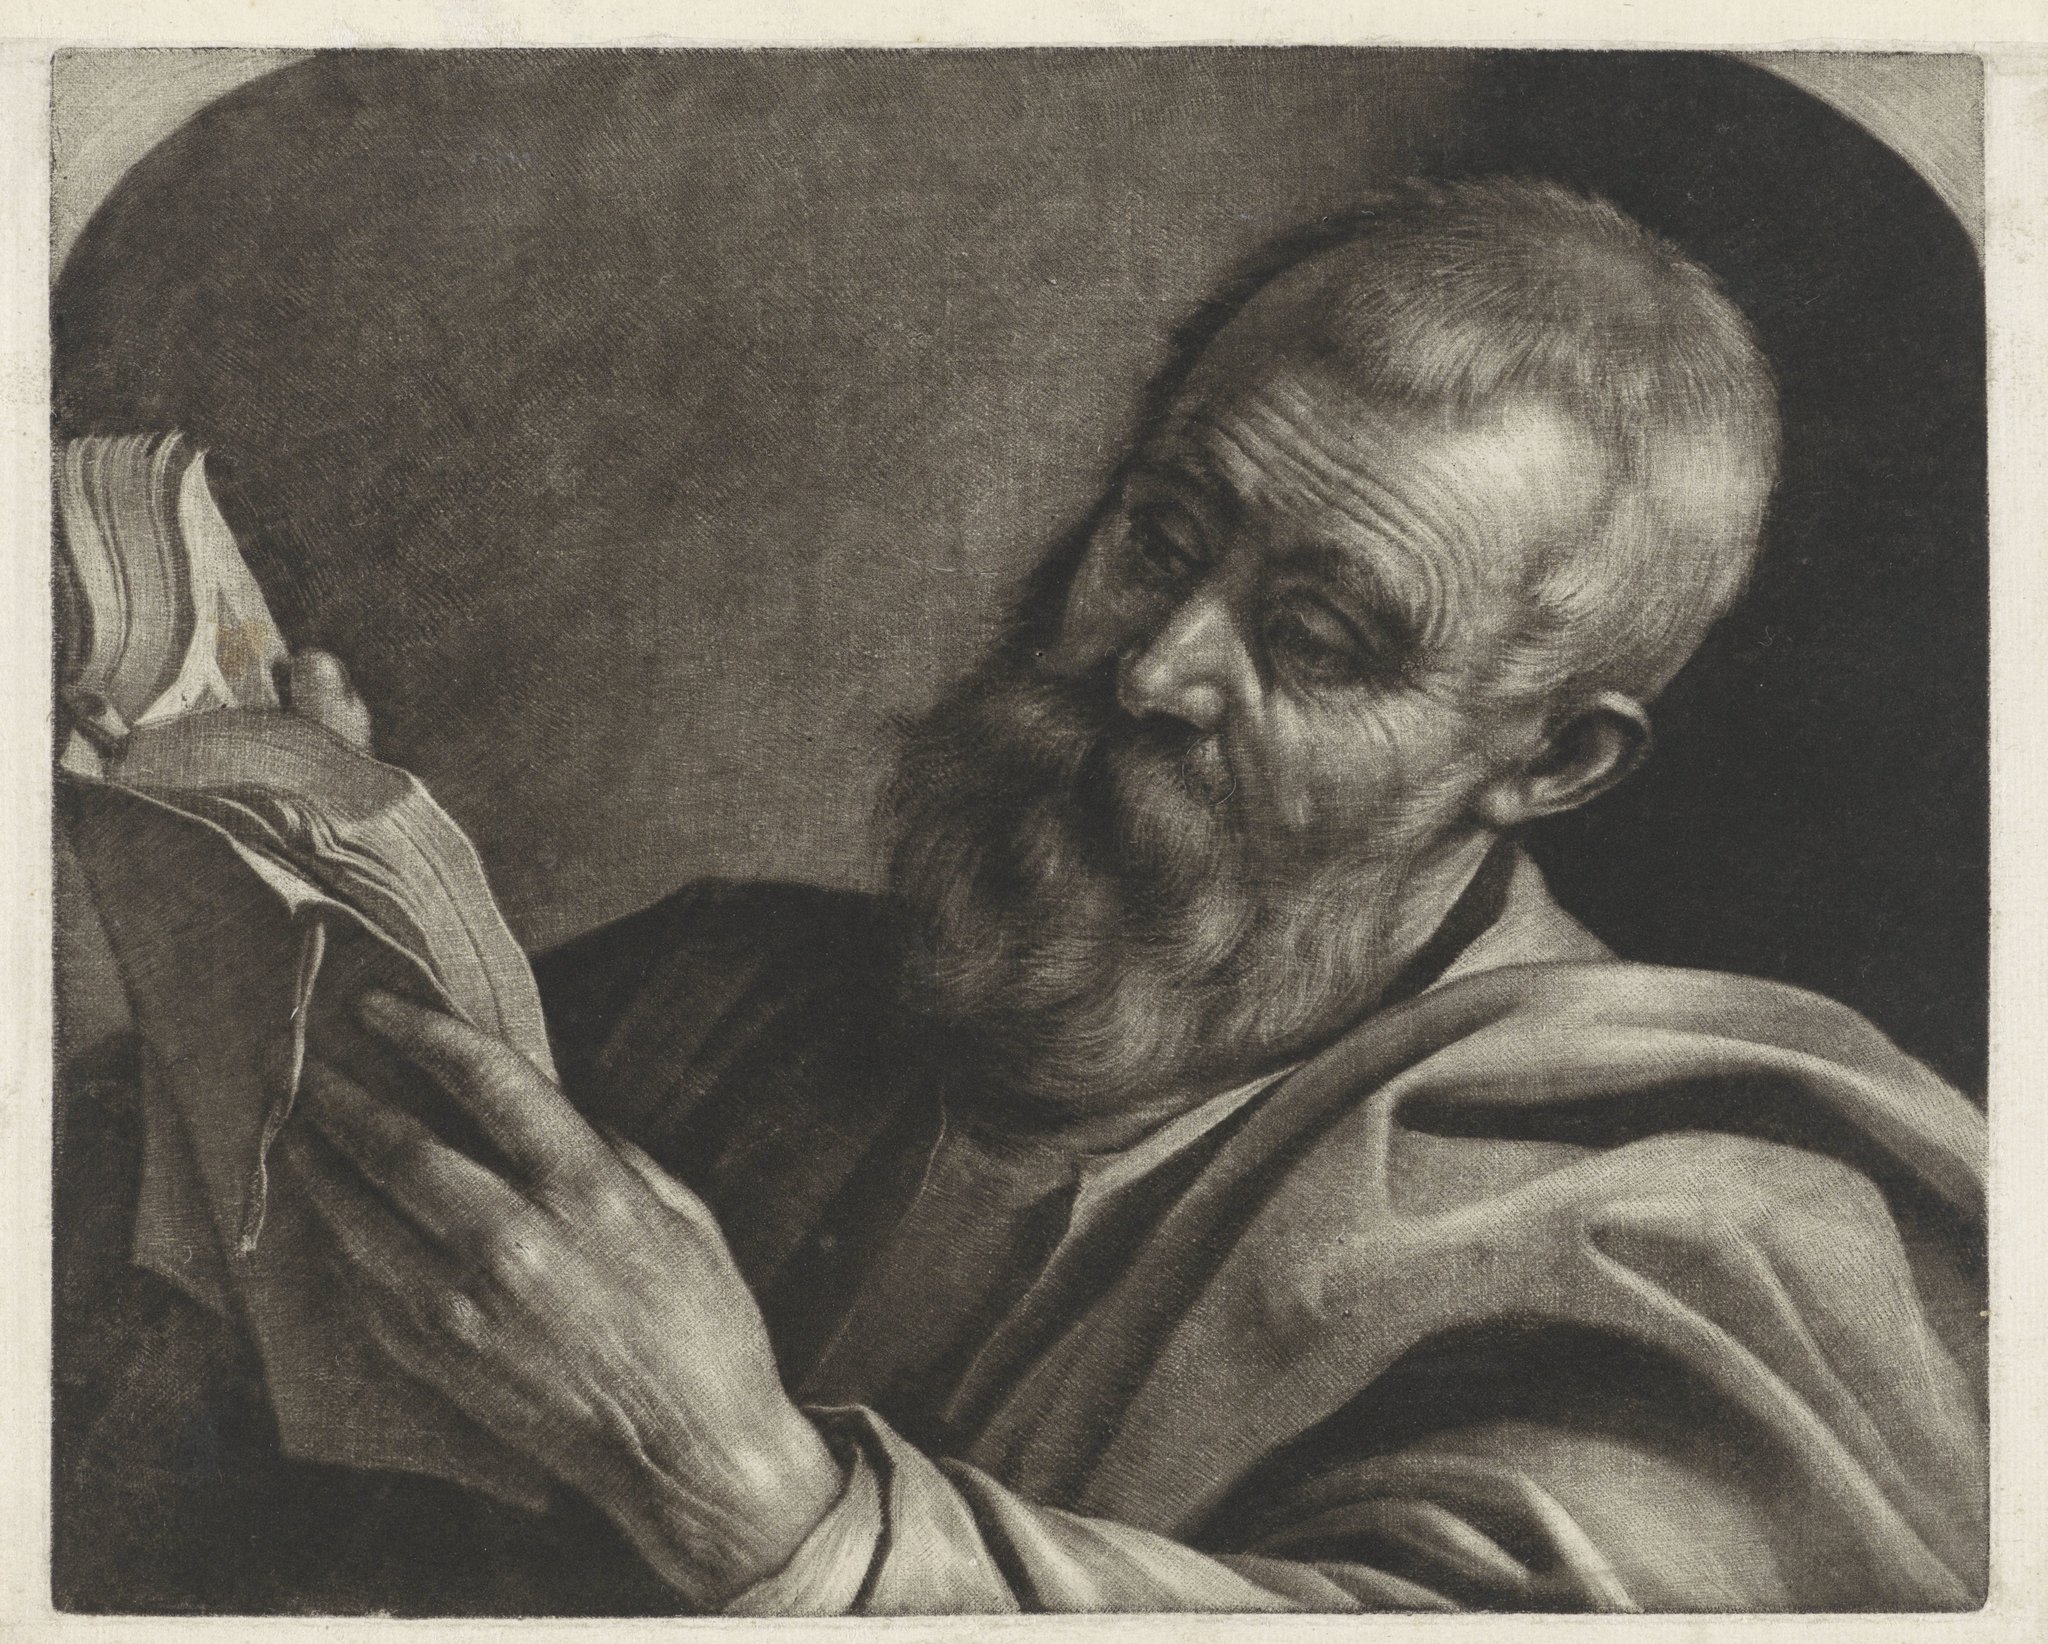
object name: print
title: Lezende man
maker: wallerant vaillant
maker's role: draughtsman, painter, print maker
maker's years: 1623-1677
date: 1658-1677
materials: paper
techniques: mezzotint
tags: reading, book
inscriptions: collector's mark: Lugt 240